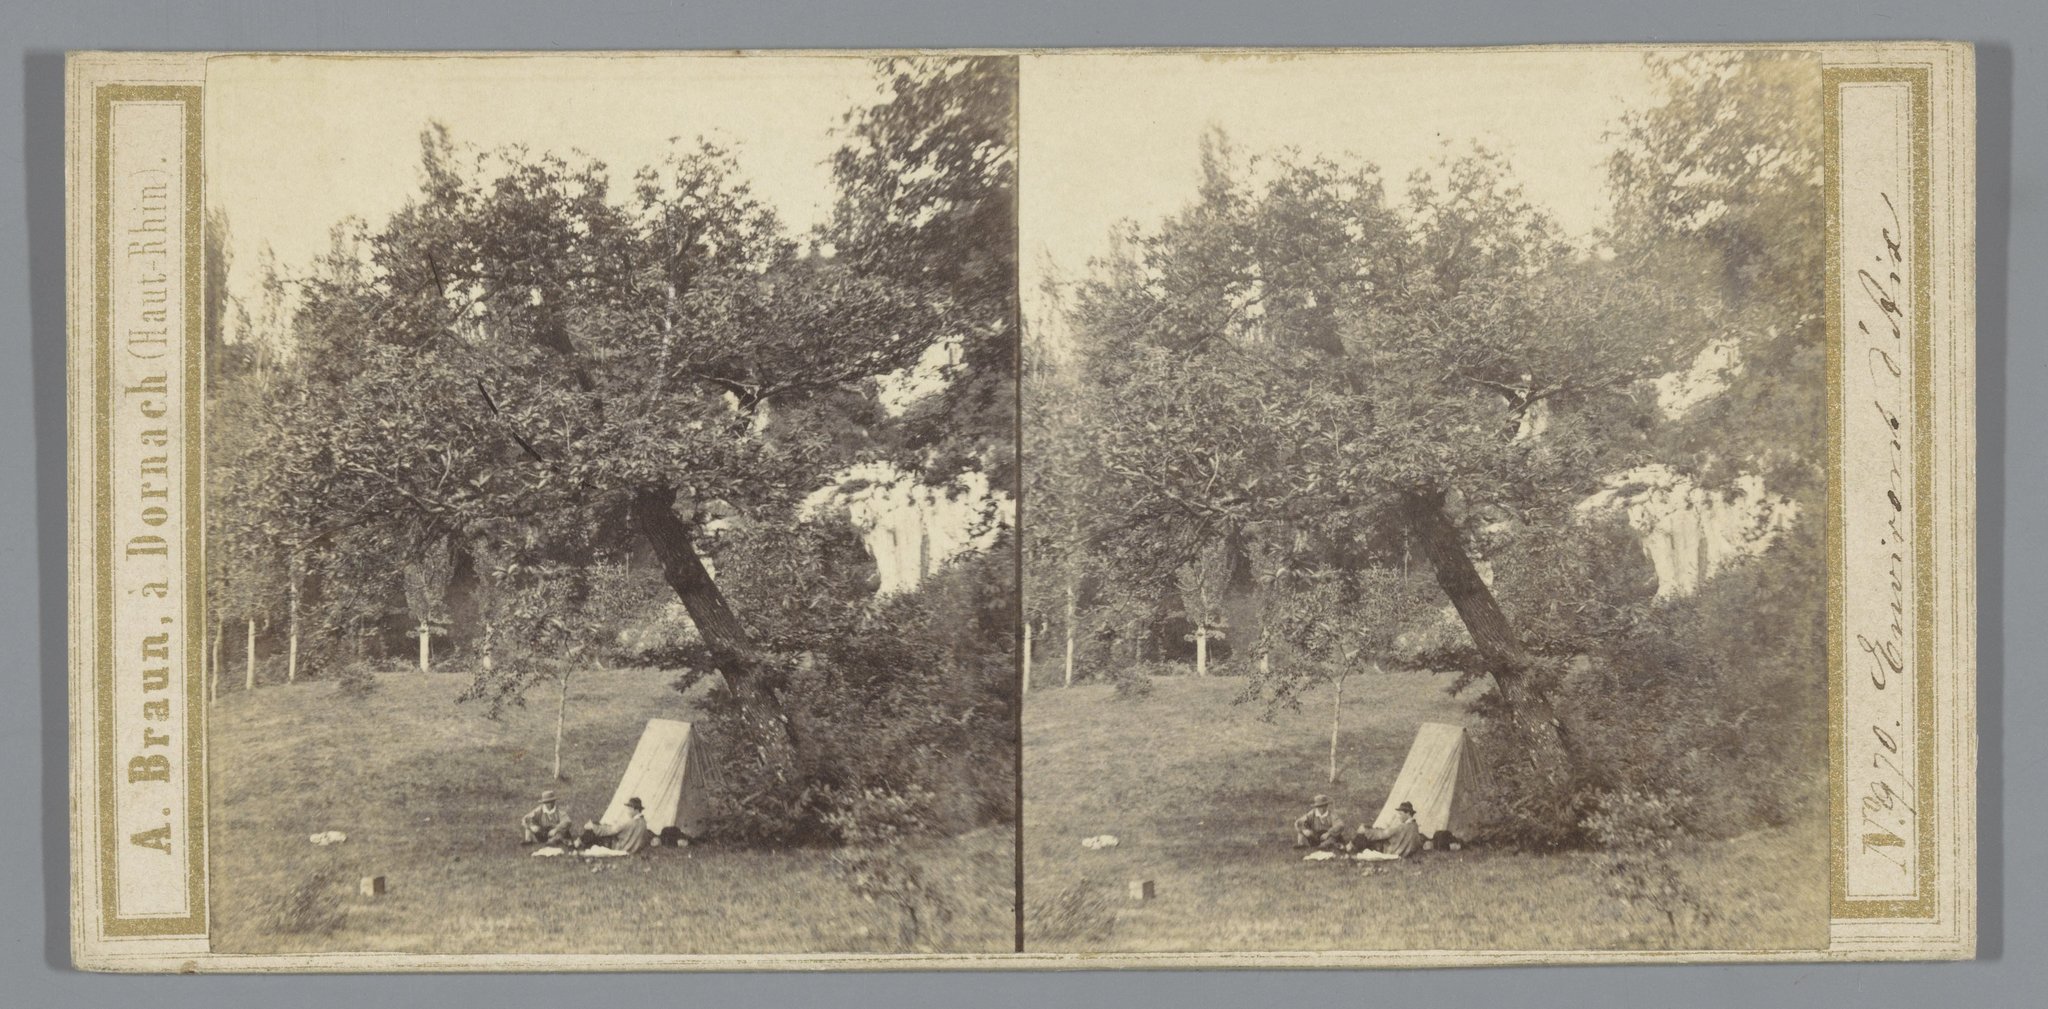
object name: stereograph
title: Kamperende mannen nabij Aix-en-Provence, Zuid-Frankrijk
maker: Anonymous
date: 1860-1866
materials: cardboard, paper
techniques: albumen print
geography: aix-en-provence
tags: tent-camp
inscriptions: number: ‘No. 970.’